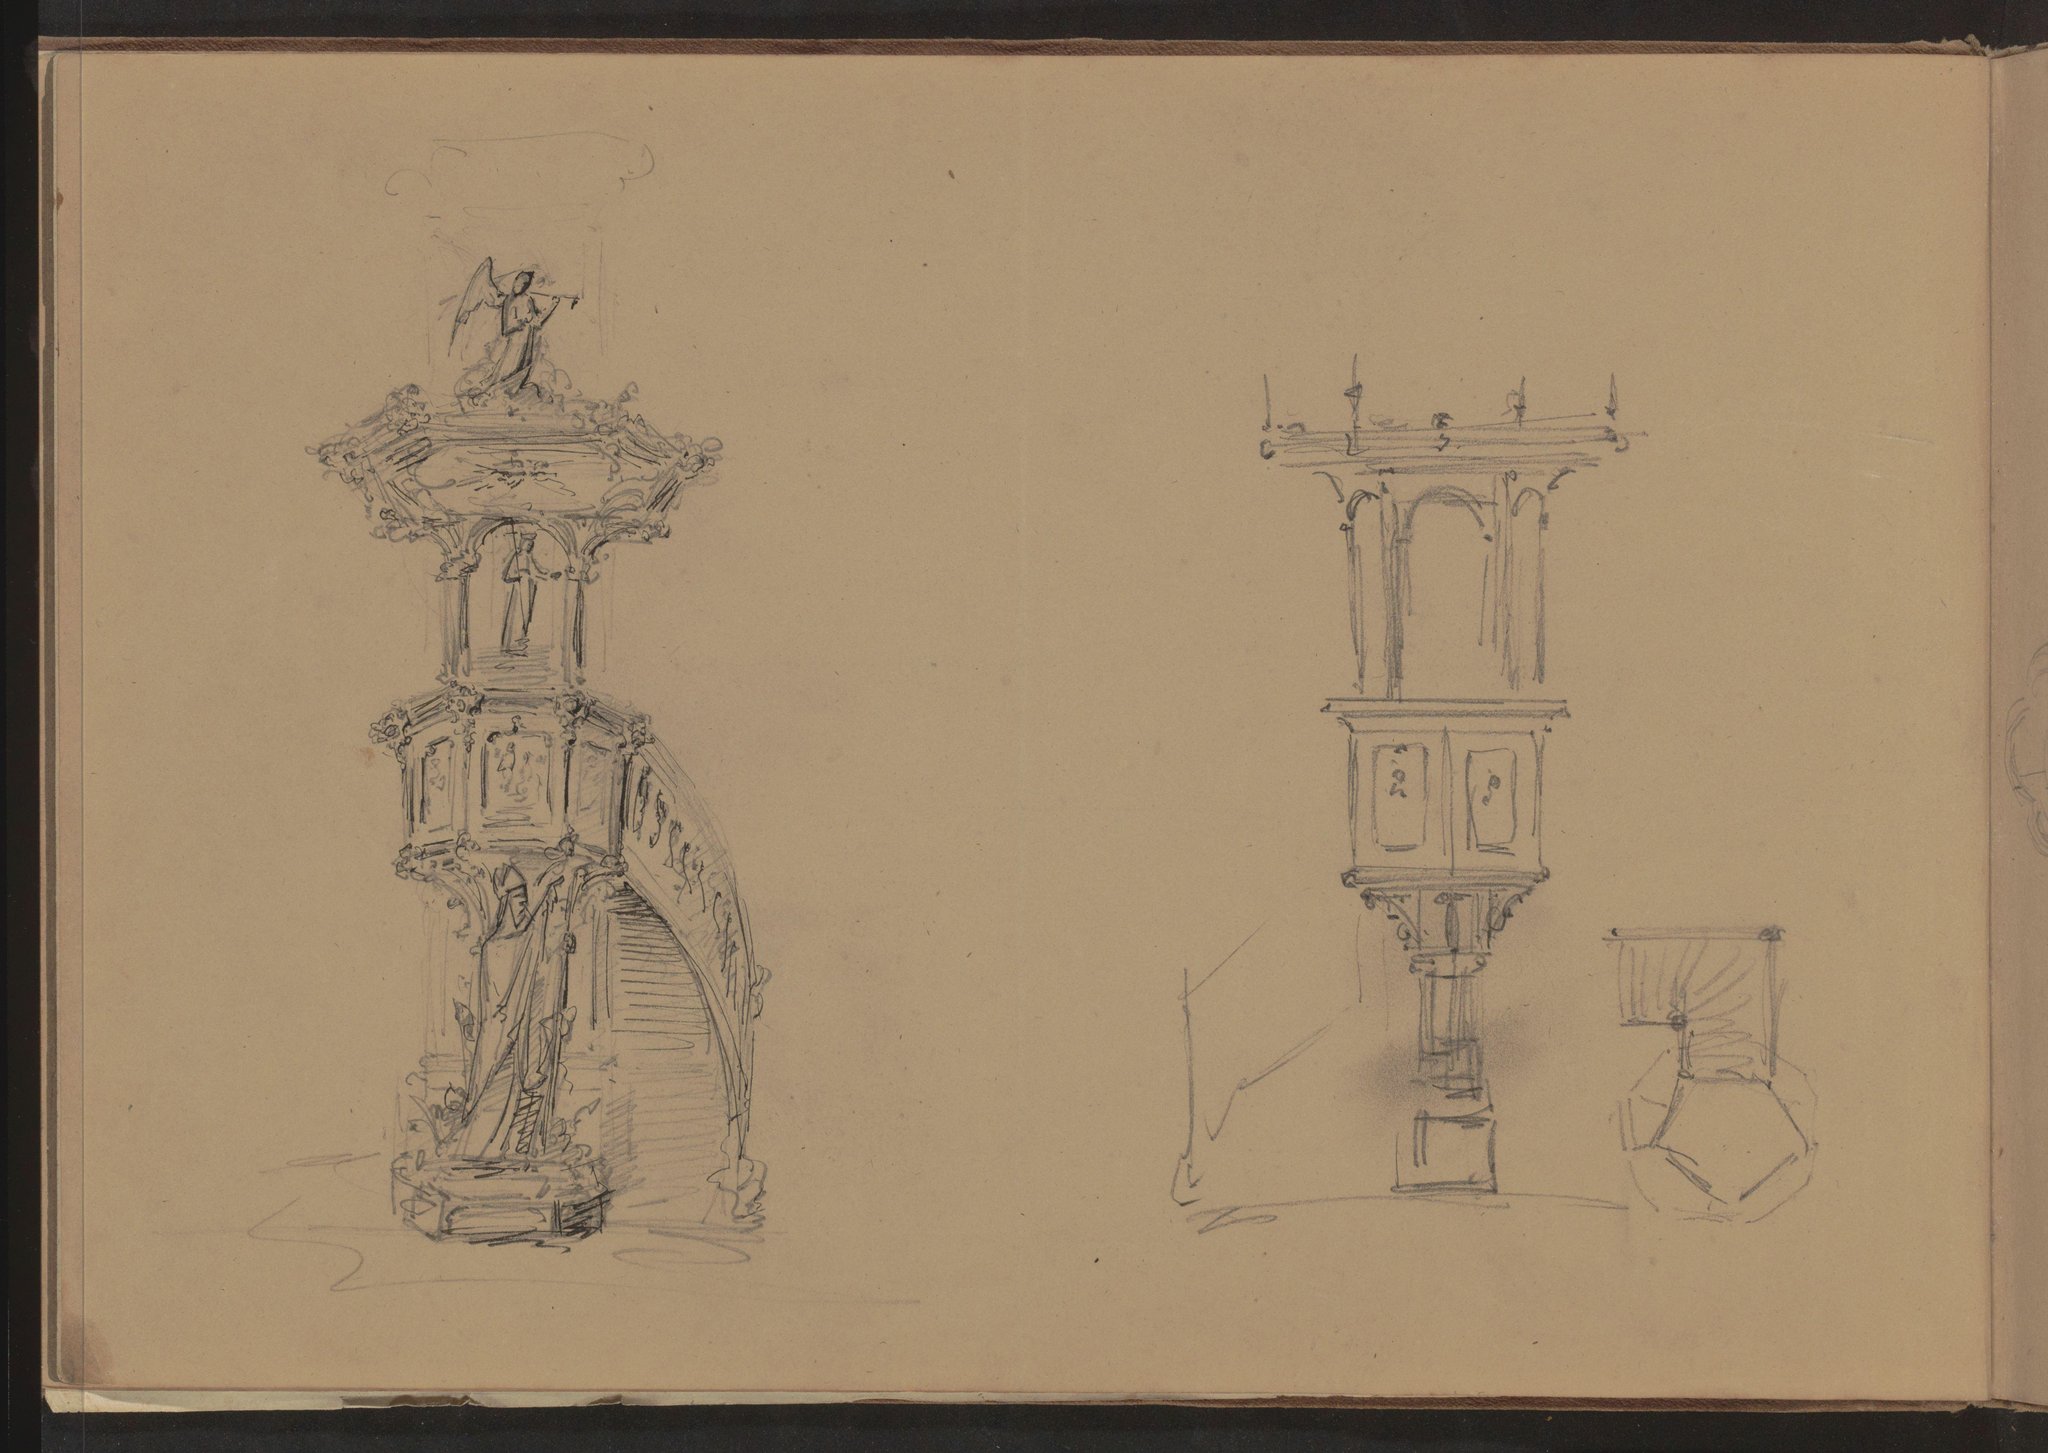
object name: sketchbook leaf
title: Preekstoelen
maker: pierre joseph hubert cuypers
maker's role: draughtsman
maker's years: 1827-1921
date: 1837-1921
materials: ink, paper, pencil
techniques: pen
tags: pulpit, ambo, chancel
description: Blad 11 verso uit een schetsboek met 23 bladen.